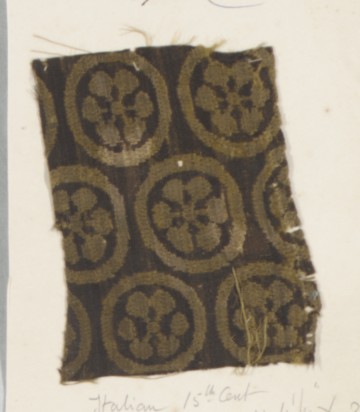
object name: fragment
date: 1401-1500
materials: silk